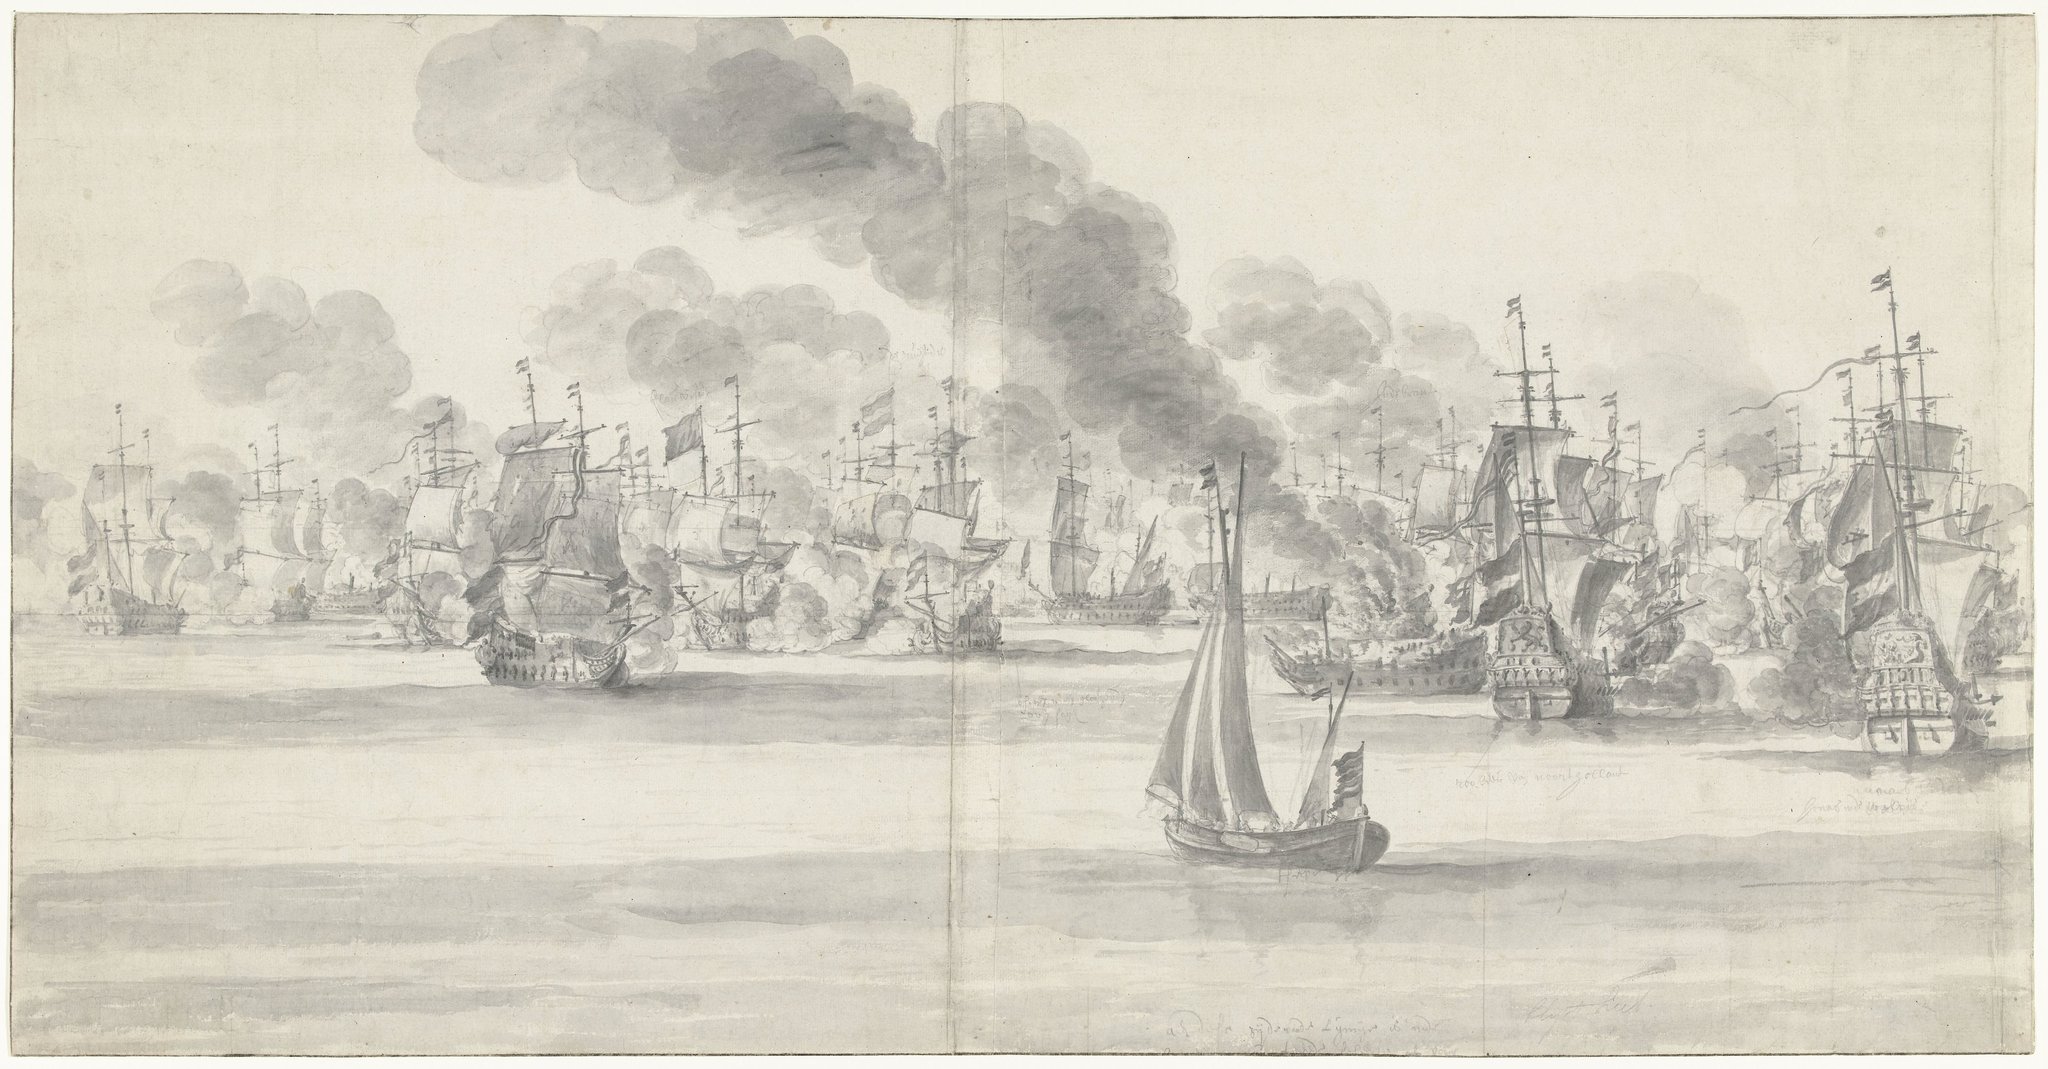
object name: drawing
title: De Zeeslag voor Katwijk (linkerblad), 1653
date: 1653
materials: paper, pencil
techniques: brush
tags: brielle, maarten harpertszoon tromp, sailing-ship, sailing-boat, names of artefacts and man-made objects (buildings excluded), sea (seascape), battle (+ sailing-ships), navy (+ sailing-ships), historical events and situations, battle of scheveningen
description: Linkerblad van een grote voorstelling in drie bladen van de zeeslag bij Terheide (Zeeslag bij Katwijk) tijdens de Eerste Engelse Oorlog tussen de Staatse vloot onder Maarten Tromp en de Engelse vloot onder George Monck, 10 augustus 1653. Met de schepen Jonas in de Walvisch, en de Roo Leeu van N. Holland.